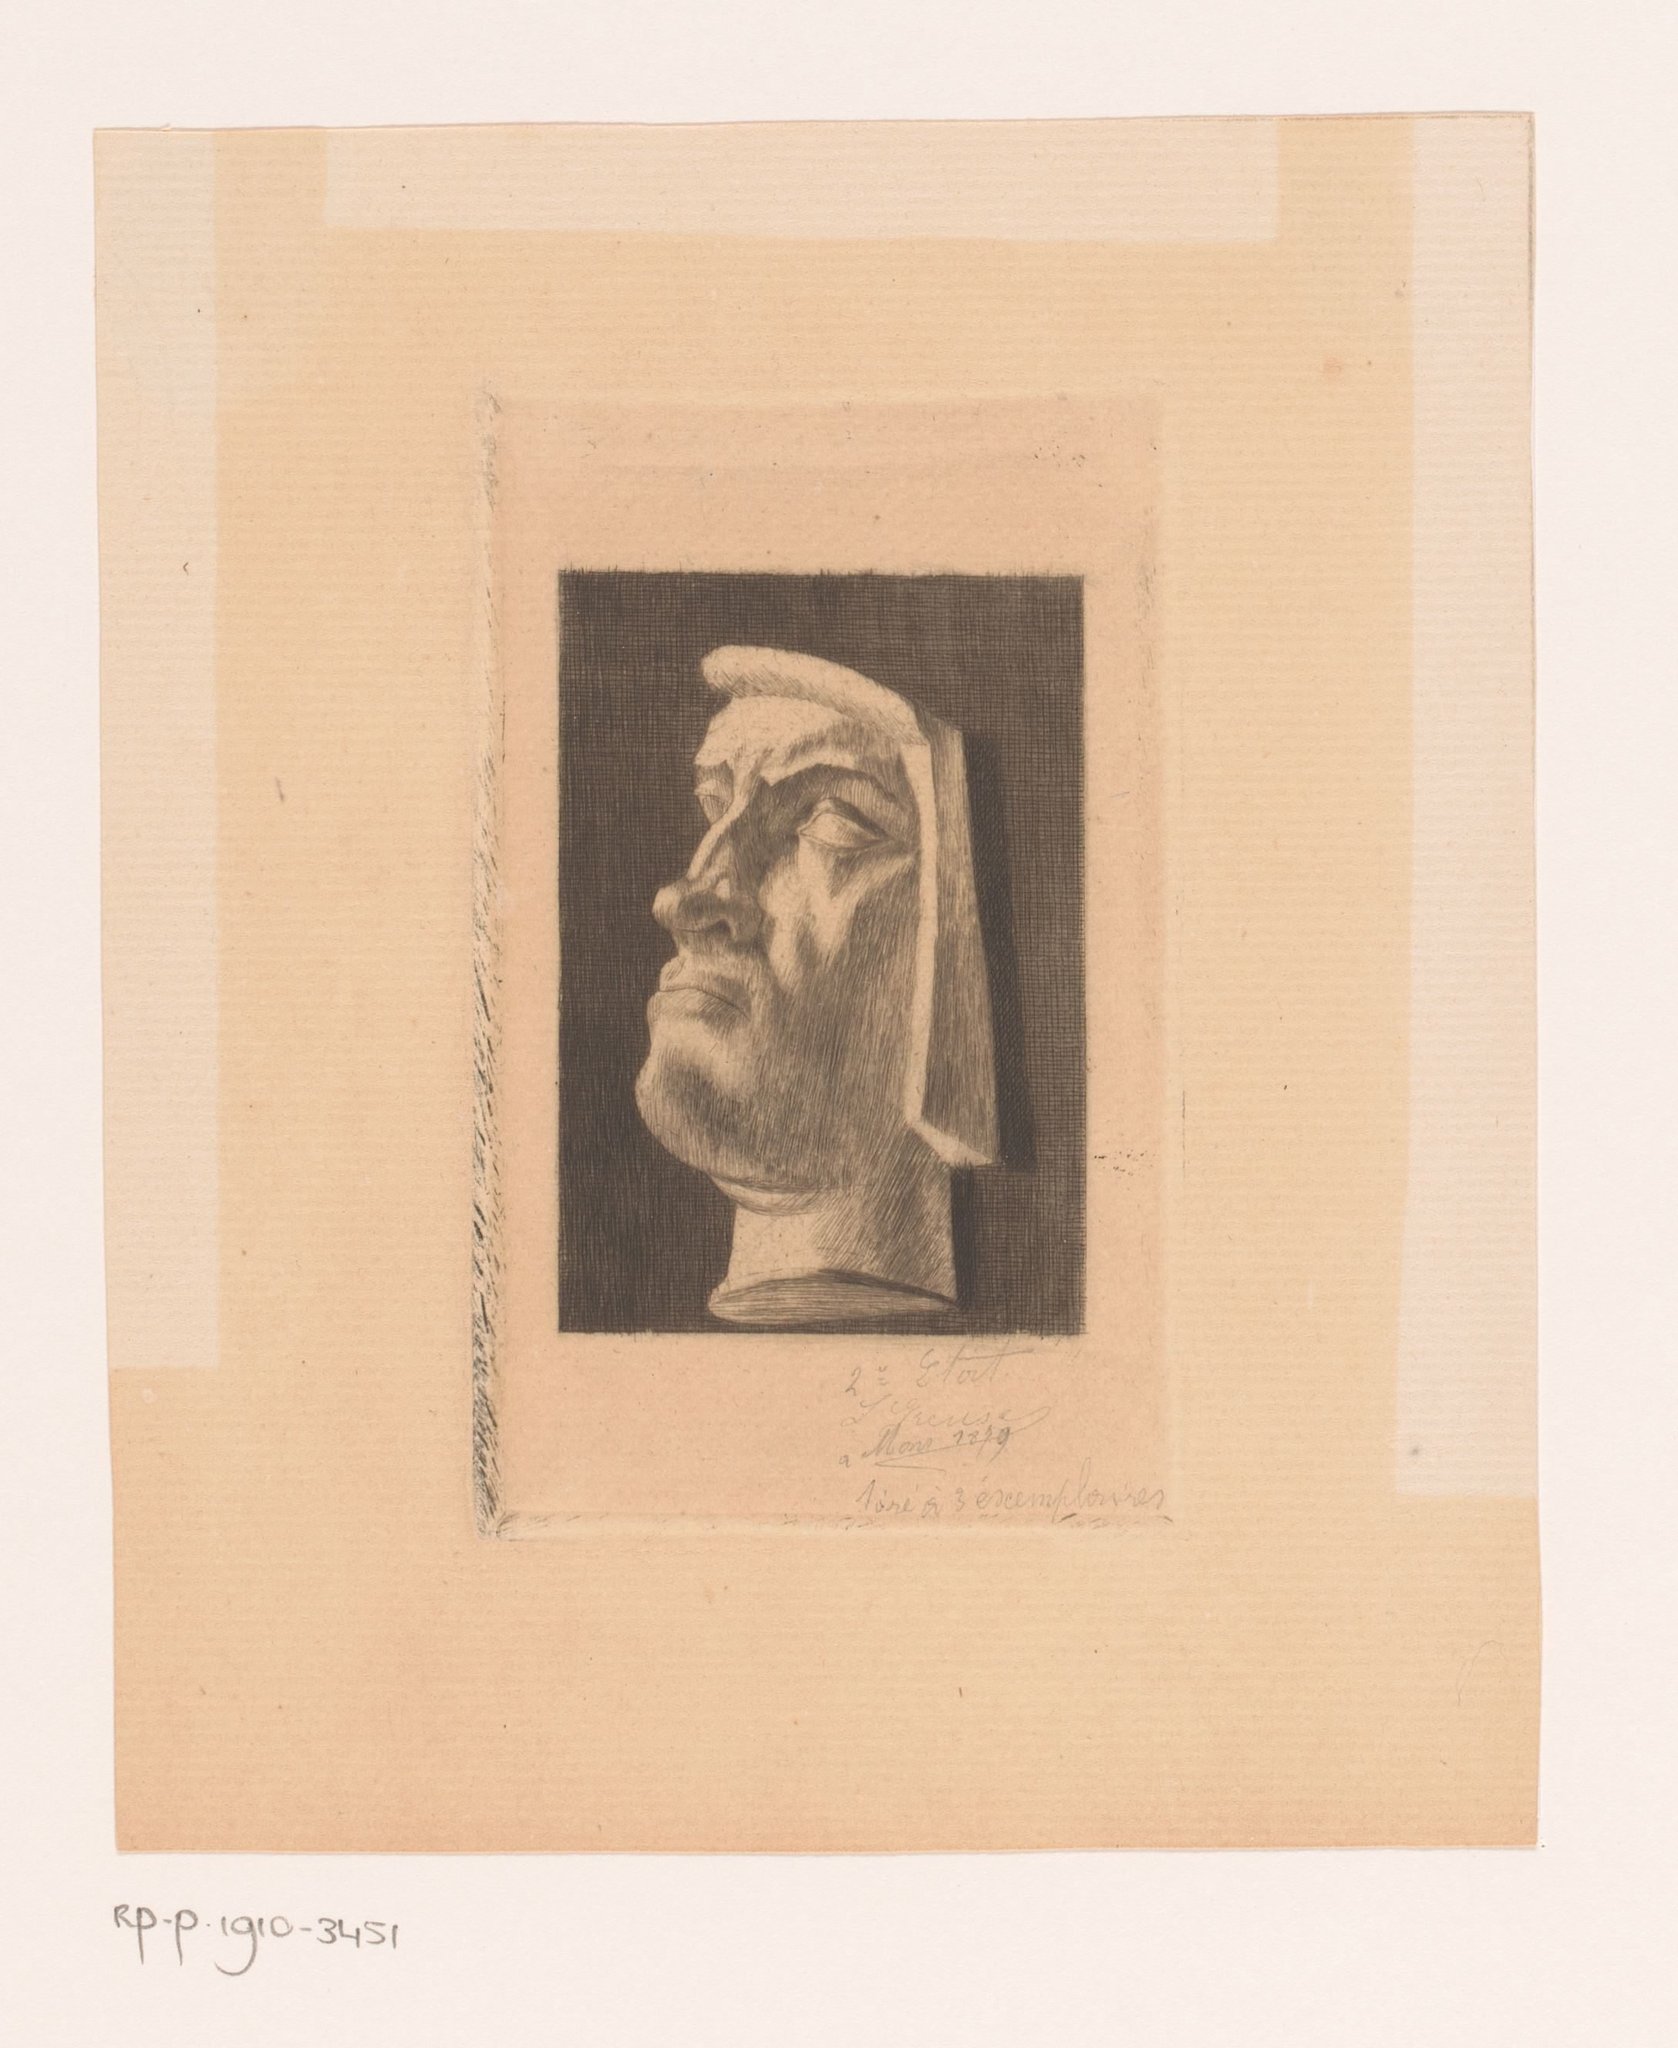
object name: print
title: Studie van een gebeeldhouwd hoofd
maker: louis joseph greuse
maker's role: print maker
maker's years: 1863-1950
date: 1879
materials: paper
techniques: etching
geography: bergen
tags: piece of sculpture, reproduction of a piece of sculpture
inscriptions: annotation: ‘2e Etat; tiré à 3 exemplaires’, collector's mark: Lugt 2228